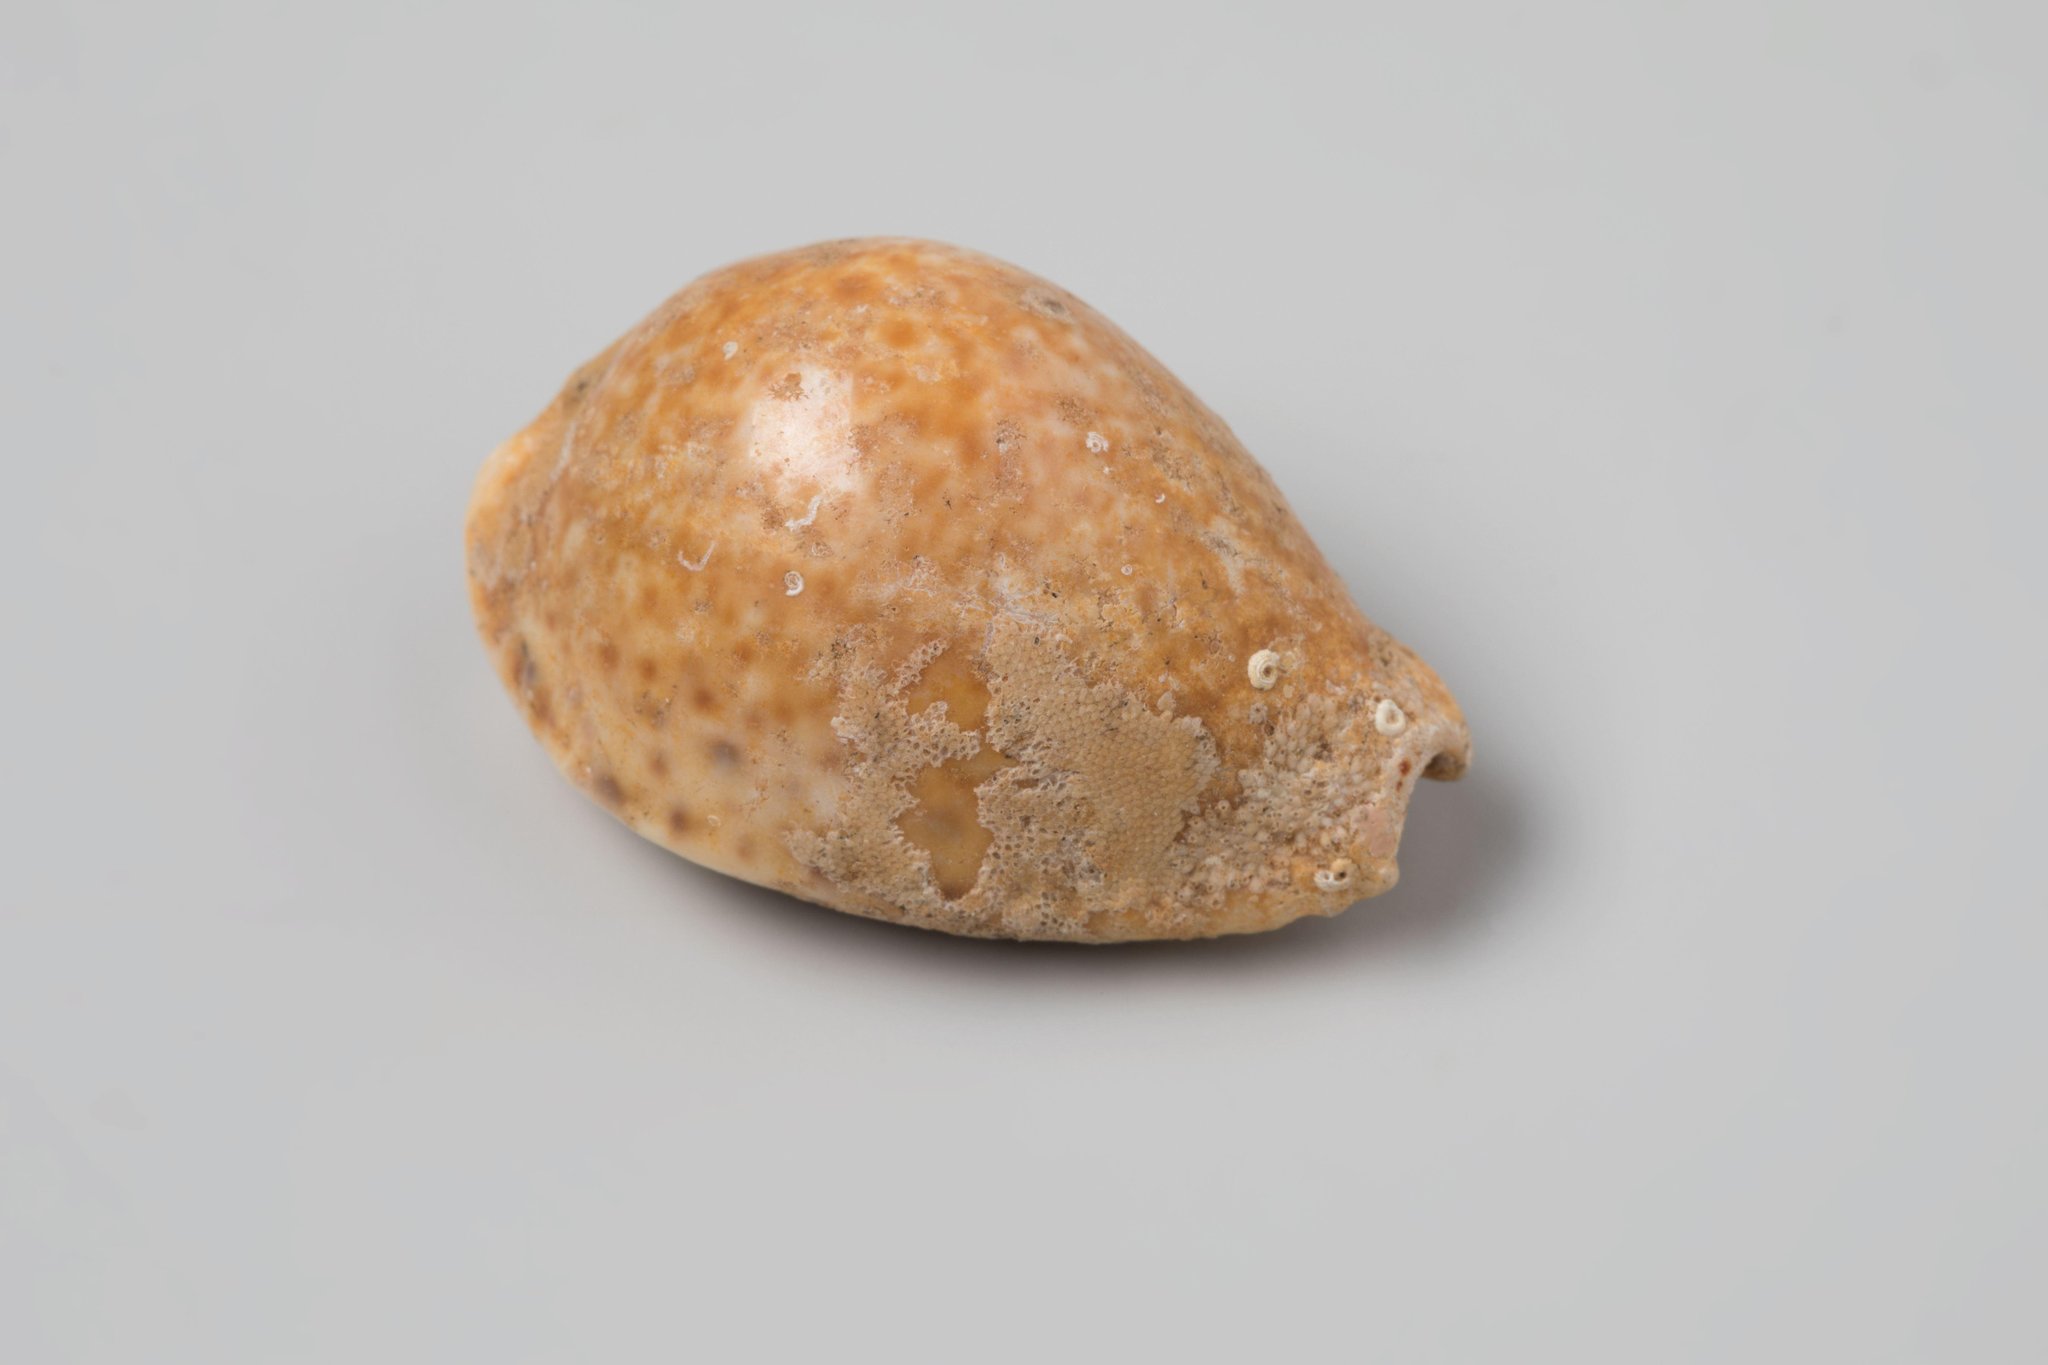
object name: erosaria spurca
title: Erosaria spurca shell from the wreck of the Dutch East India ship Witte Leeuw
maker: niet van toepassing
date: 1613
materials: shell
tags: verenigde oostindische compagnie, sint-helena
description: Schelp uit V.O.C.-schip de 'Witte Leeuw'.